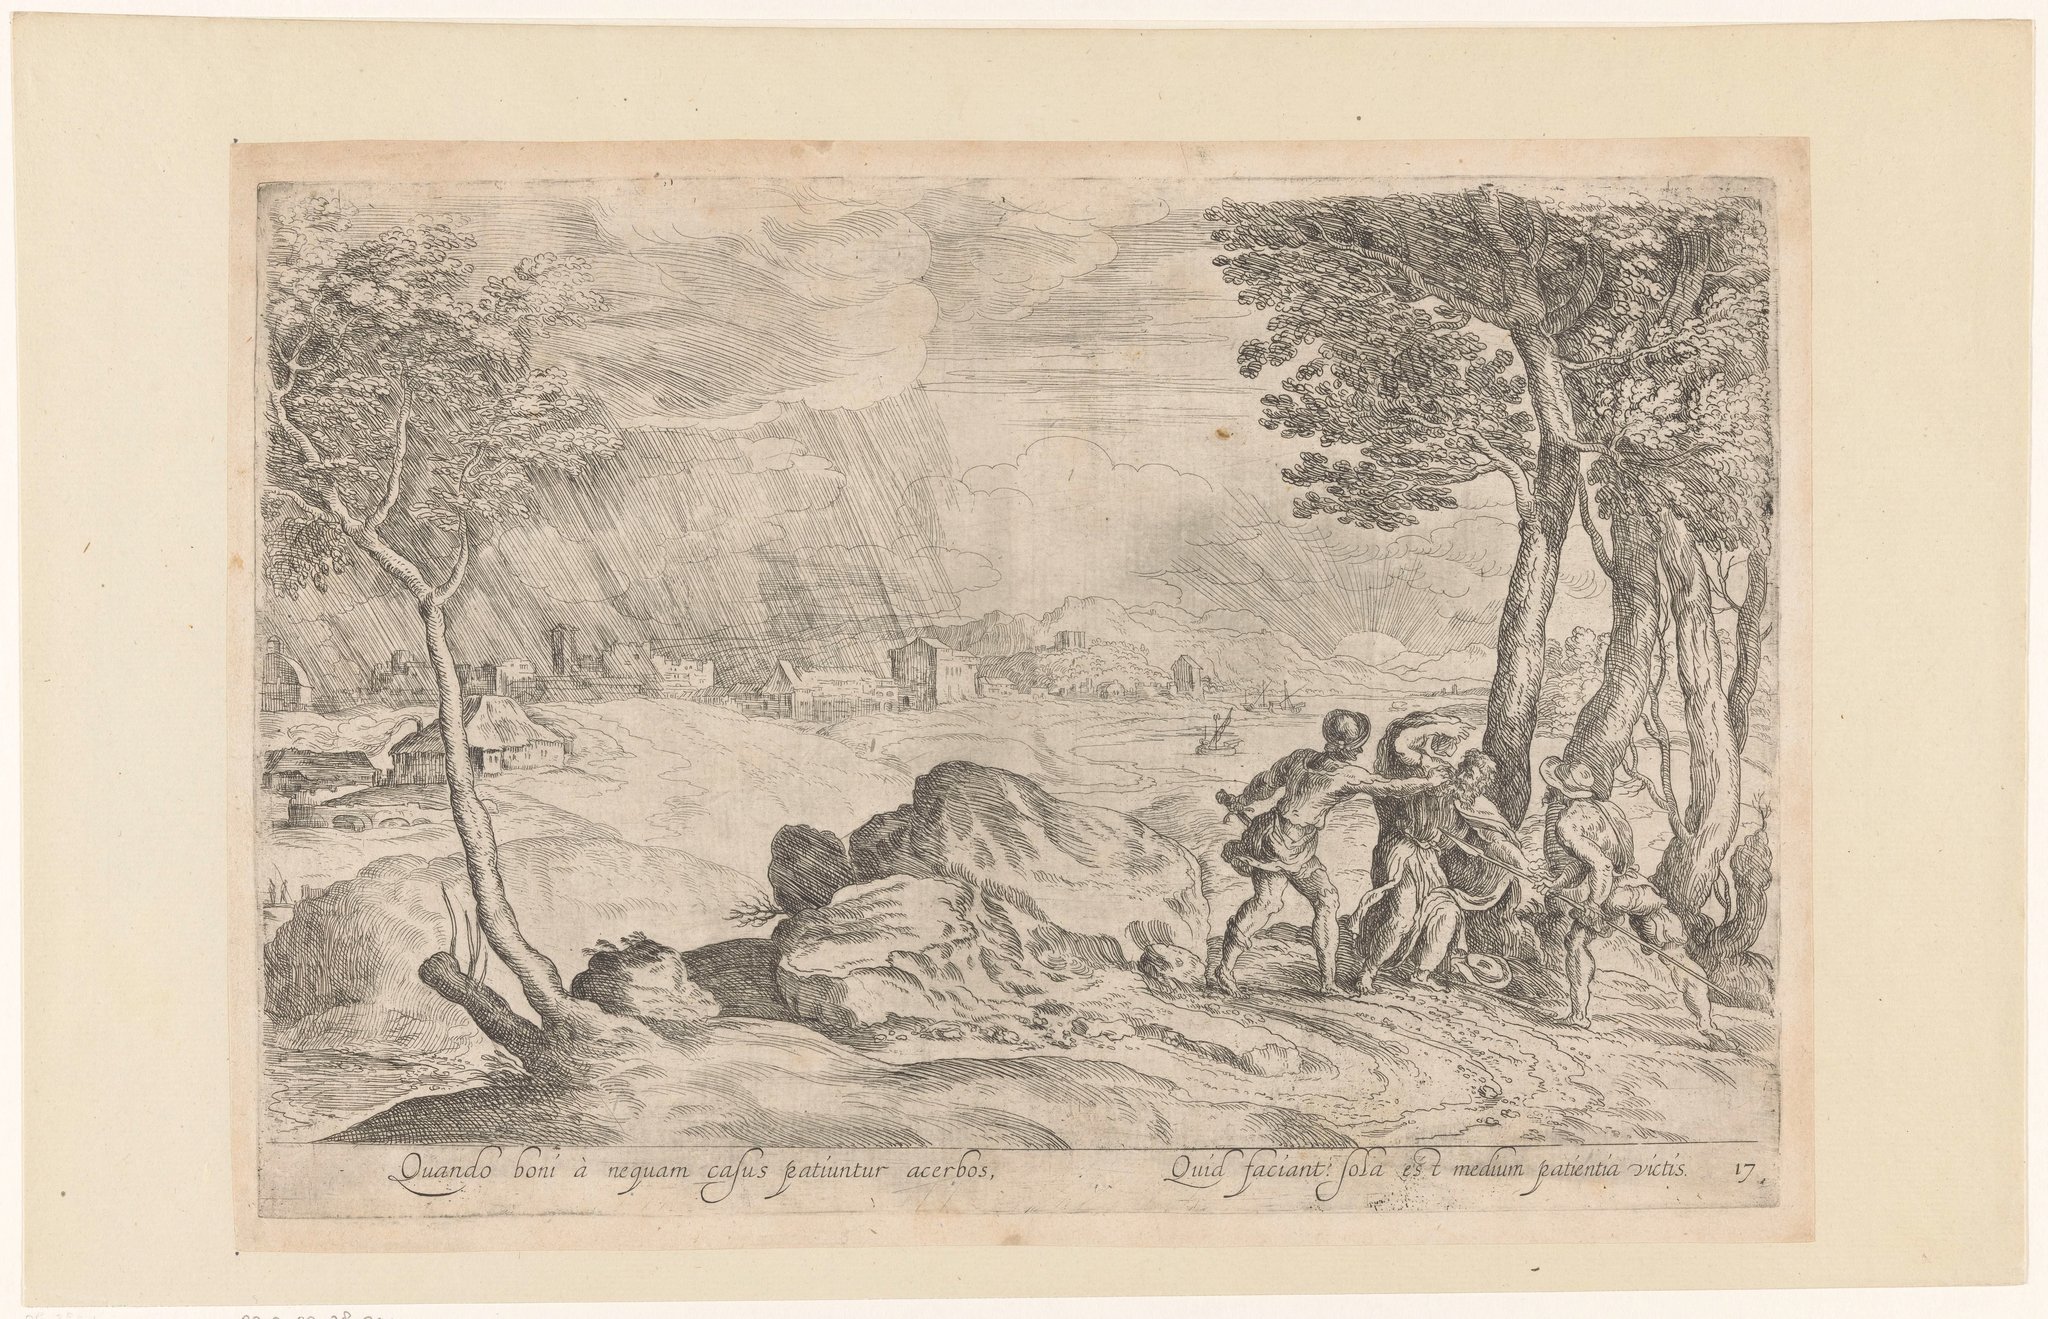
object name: print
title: Quando boni à nequam casus patiuntur acerbos, / Quid faciant sola est medium patientia victis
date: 1600-1699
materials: paper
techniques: etching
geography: italy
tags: landscapes, river, traveller(s) attacked by robber(s)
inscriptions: collector's mark: Lugt 2228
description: Een landschap met een rivier en een dorp links. Op de voorgrond rechts twee rover die een oude man belagen. Titel in het Latijn in ondermarge. Genummerd rechtsonder: 17.